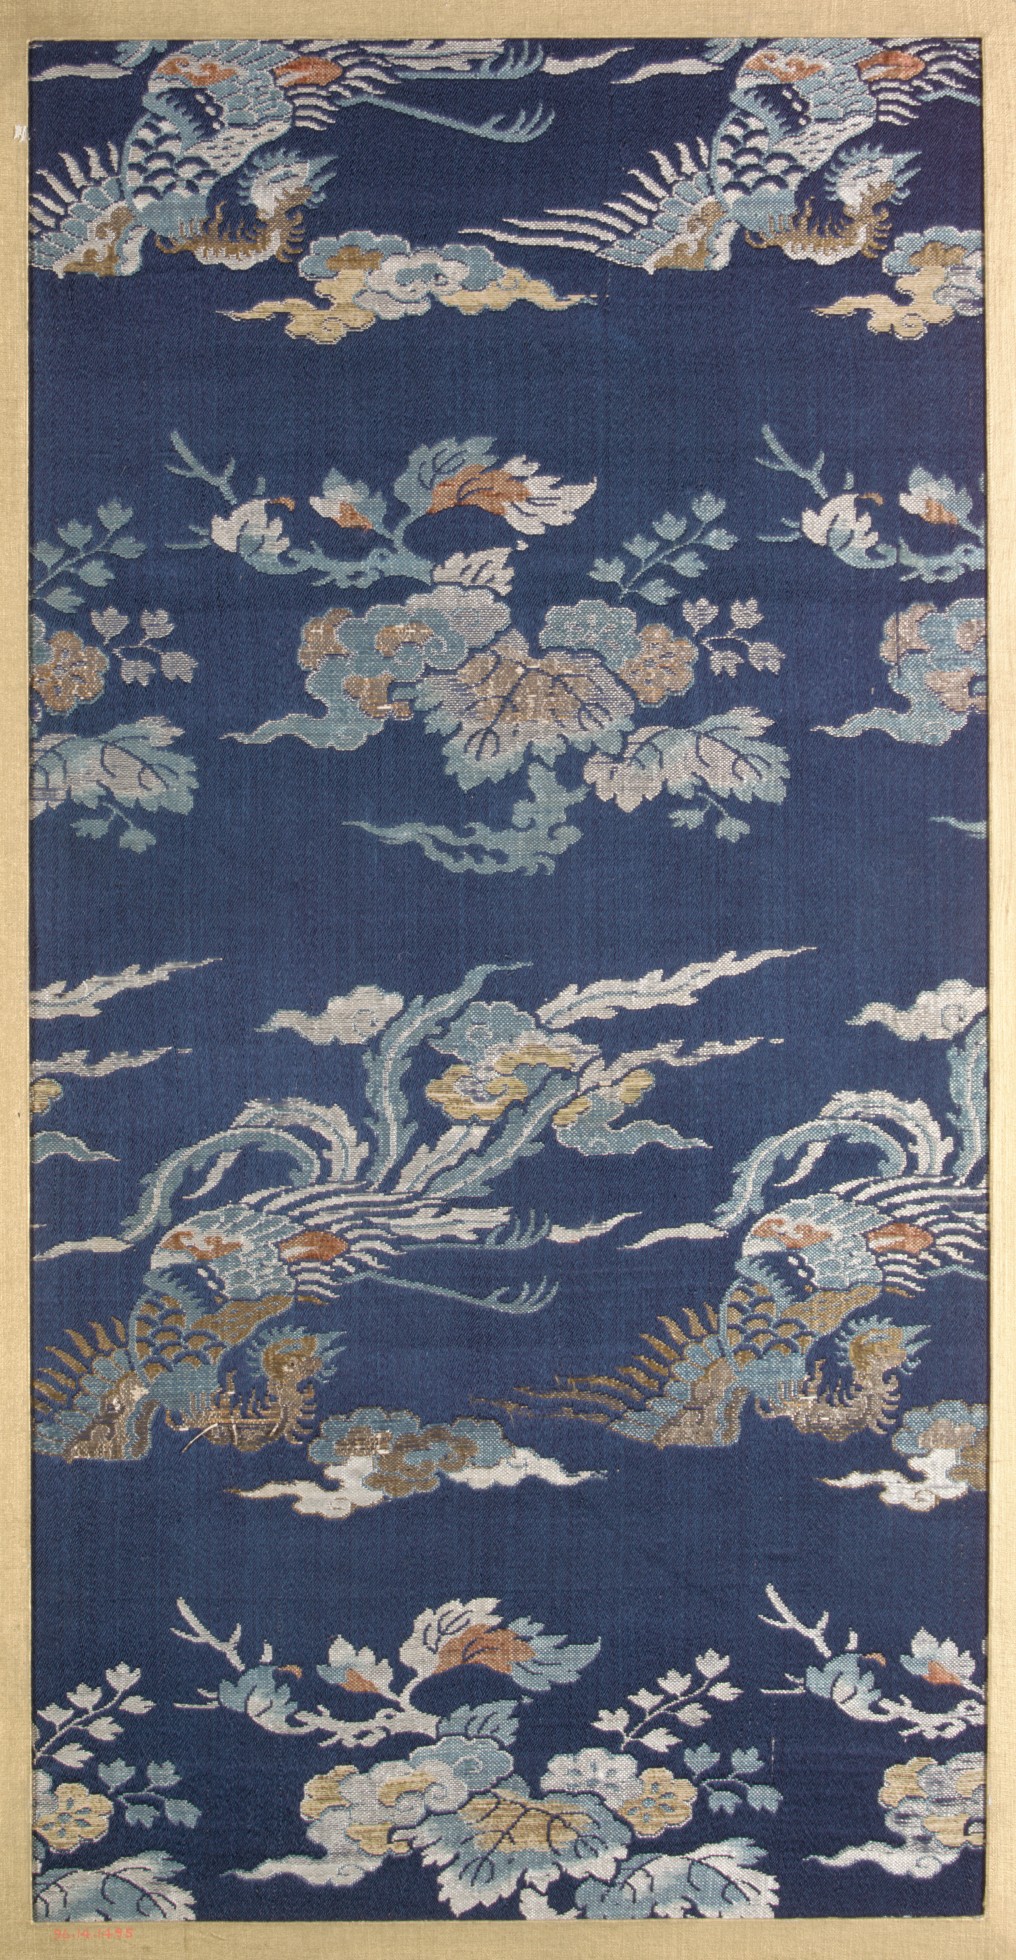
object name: piece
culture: japanese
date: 1701-1900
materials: silk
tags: phoenix